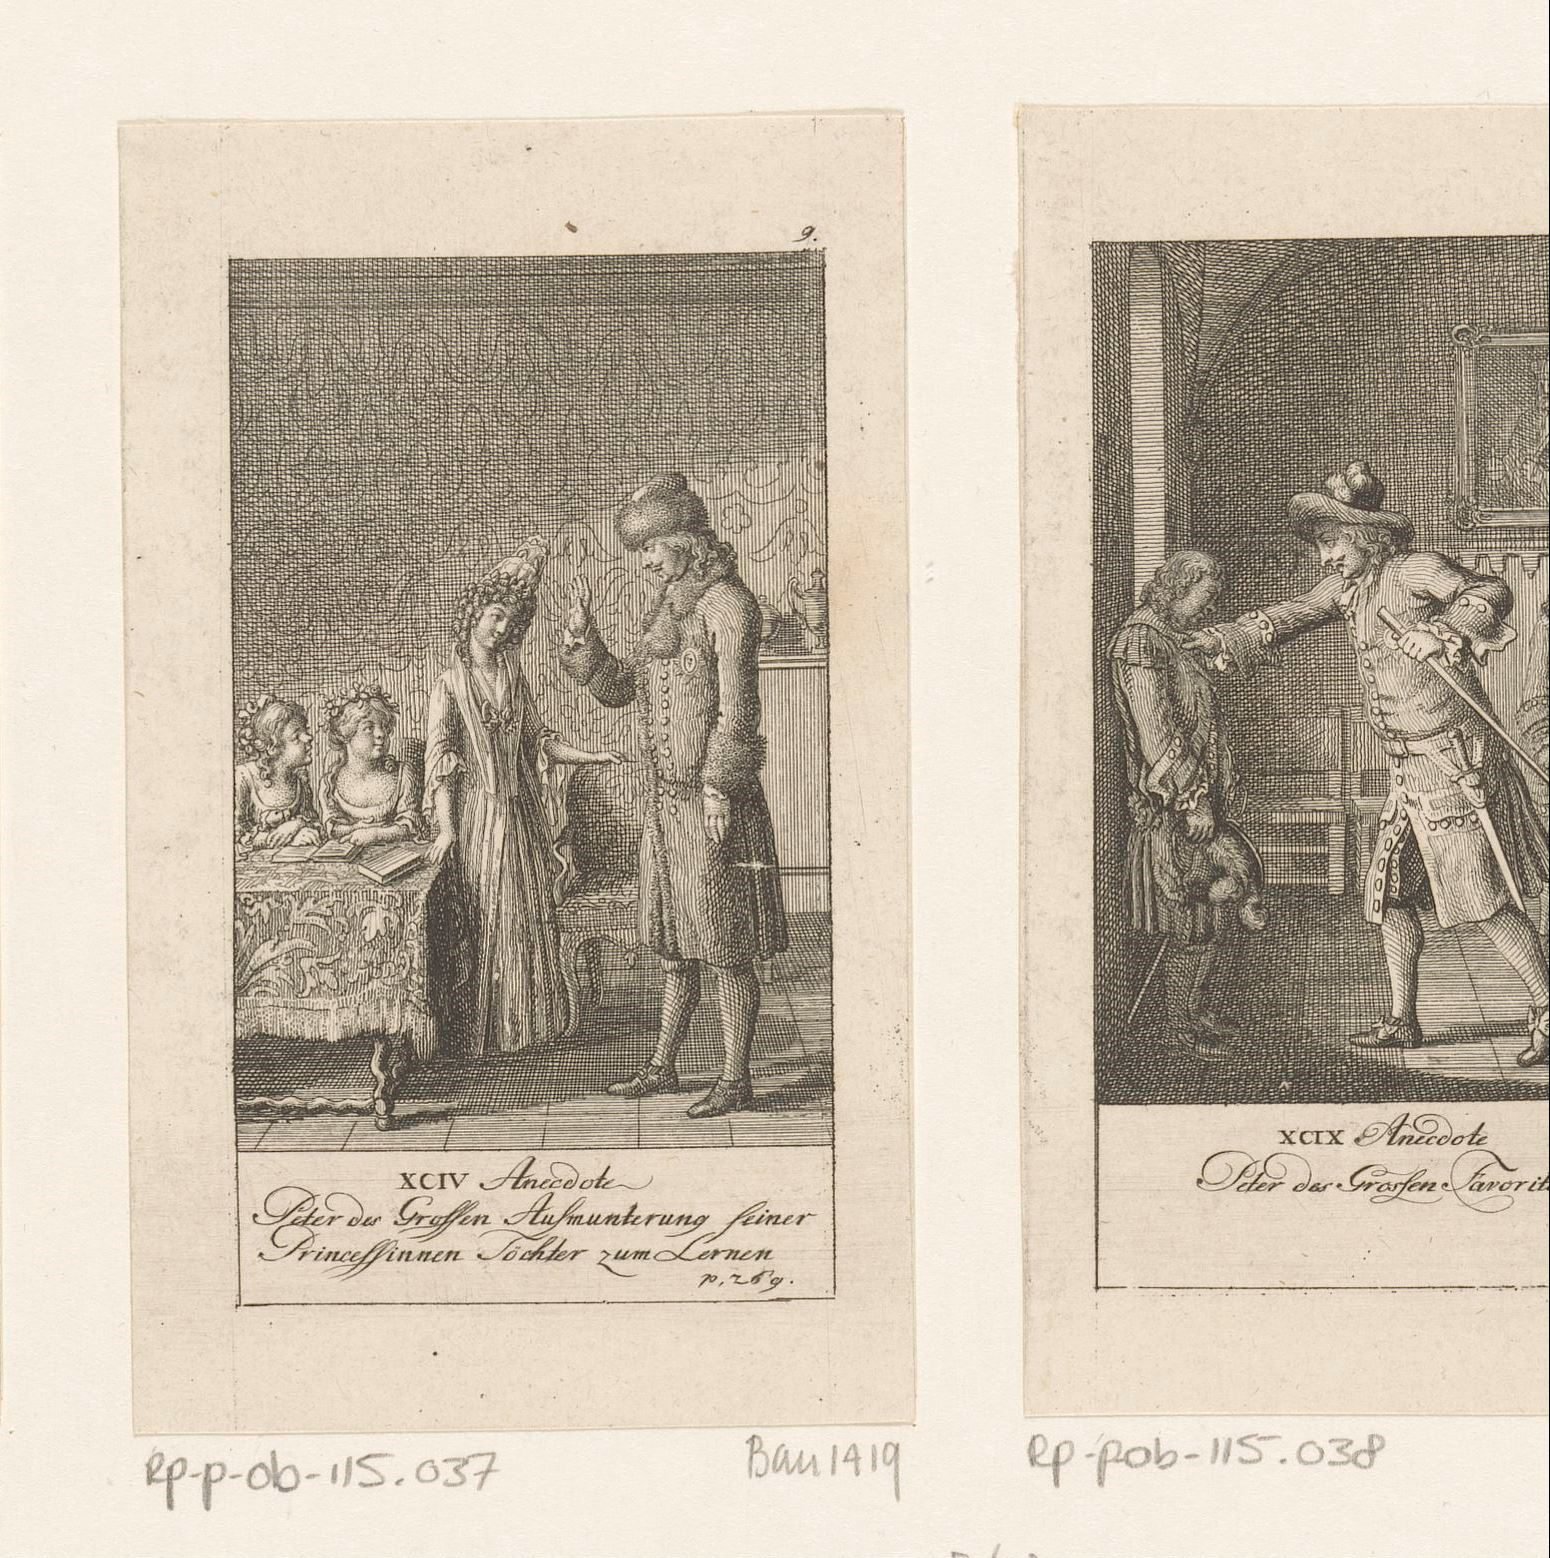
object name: book illustration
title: Peter de Grote bij zijn dochters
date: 1789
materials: paper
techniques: etching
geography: gottingen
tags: peter i de grote (tsaar van rusland), father and daughter(s) (family group), history, emperor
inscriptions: collector's mark: Lugt 2228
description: Vervaardigd voor 'Anekdoten vom Peter dem Grossen'. Prent gebruikt voor: Goettinger Taschen Calender vom Jahr 1790. Göttingen: Johann Christoph Dietrich, [1789].